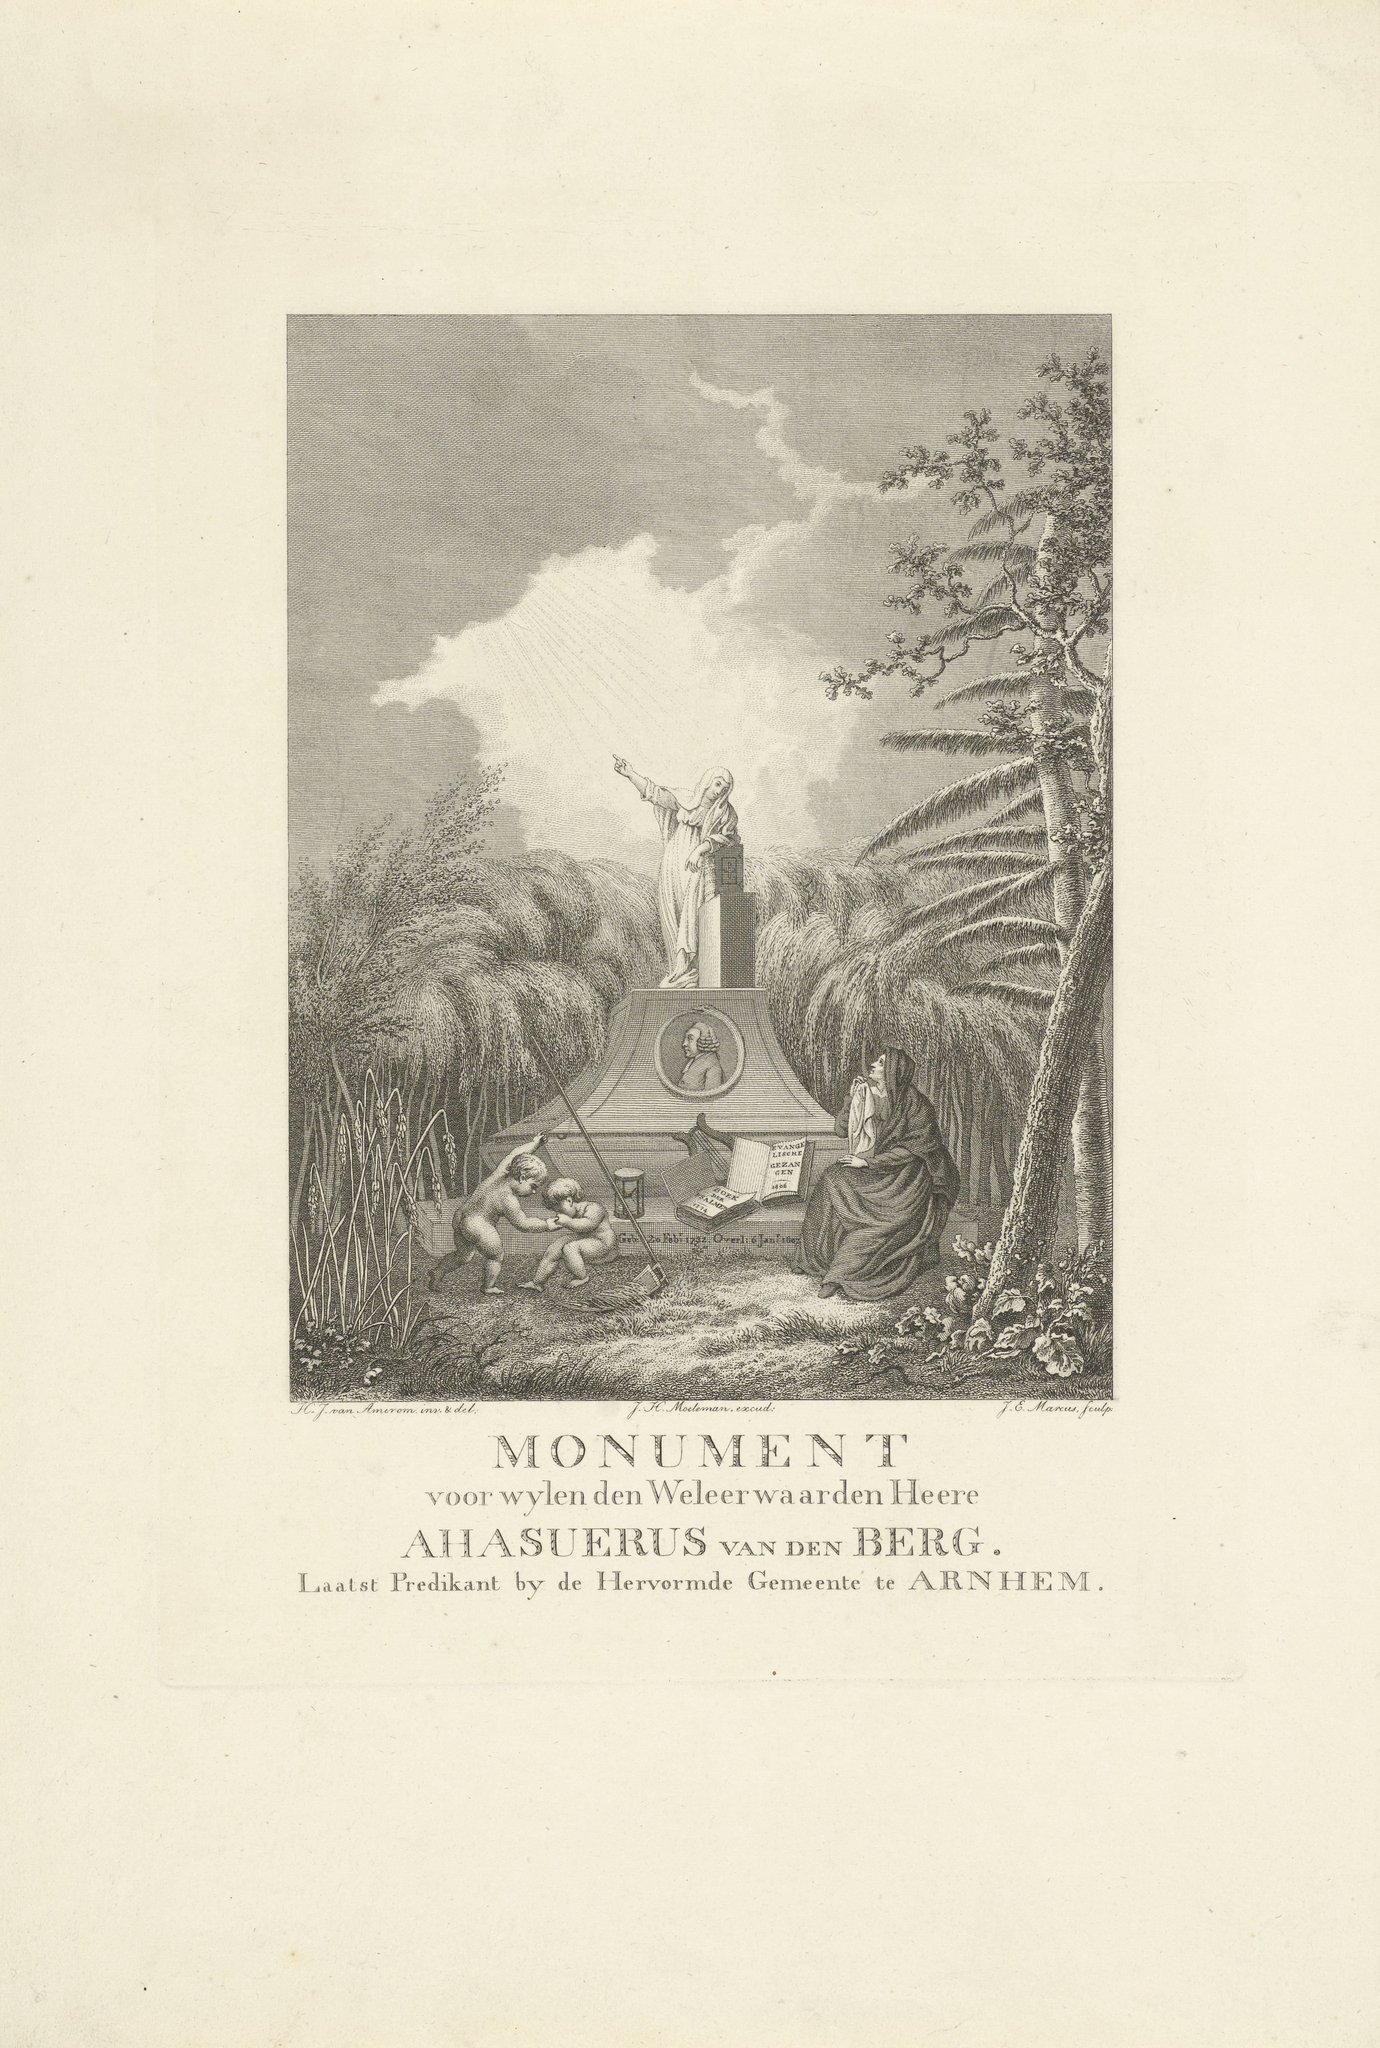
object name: print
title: Grafmonument voor Ahasverus van den Berg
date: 1807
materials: paper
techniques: etching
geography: arnhem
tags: dordrecht, arnhem, serpent ouroboros, weeping, grave-building, monumental tomb, (rays of) light ~ symbol of god the father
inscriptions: collector's mark: Lugt 2228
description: Het grafmonument van de predikant Ahasverus van den Berg met zijn portret, omlijst met een ouroboros als symbool voor de eeuwigheid. Bij het monument kijkt een treurende vrouw omhoog naar een vrouwenfiguur die op een bijbel op een sokkel leunt en met een hand naar een open plek tussen de wolken wijst waar lichtstralen uitkomen. Op het grafmonument liggen een zandloper en een lier en twee boeken van de overleden predikant, Evangelische zangen uit 1806 en Boek der Psalmen uit 1774. Tegen het monument staat tevens een zeis en op de voorgrond spelen twee naakte kinderen.